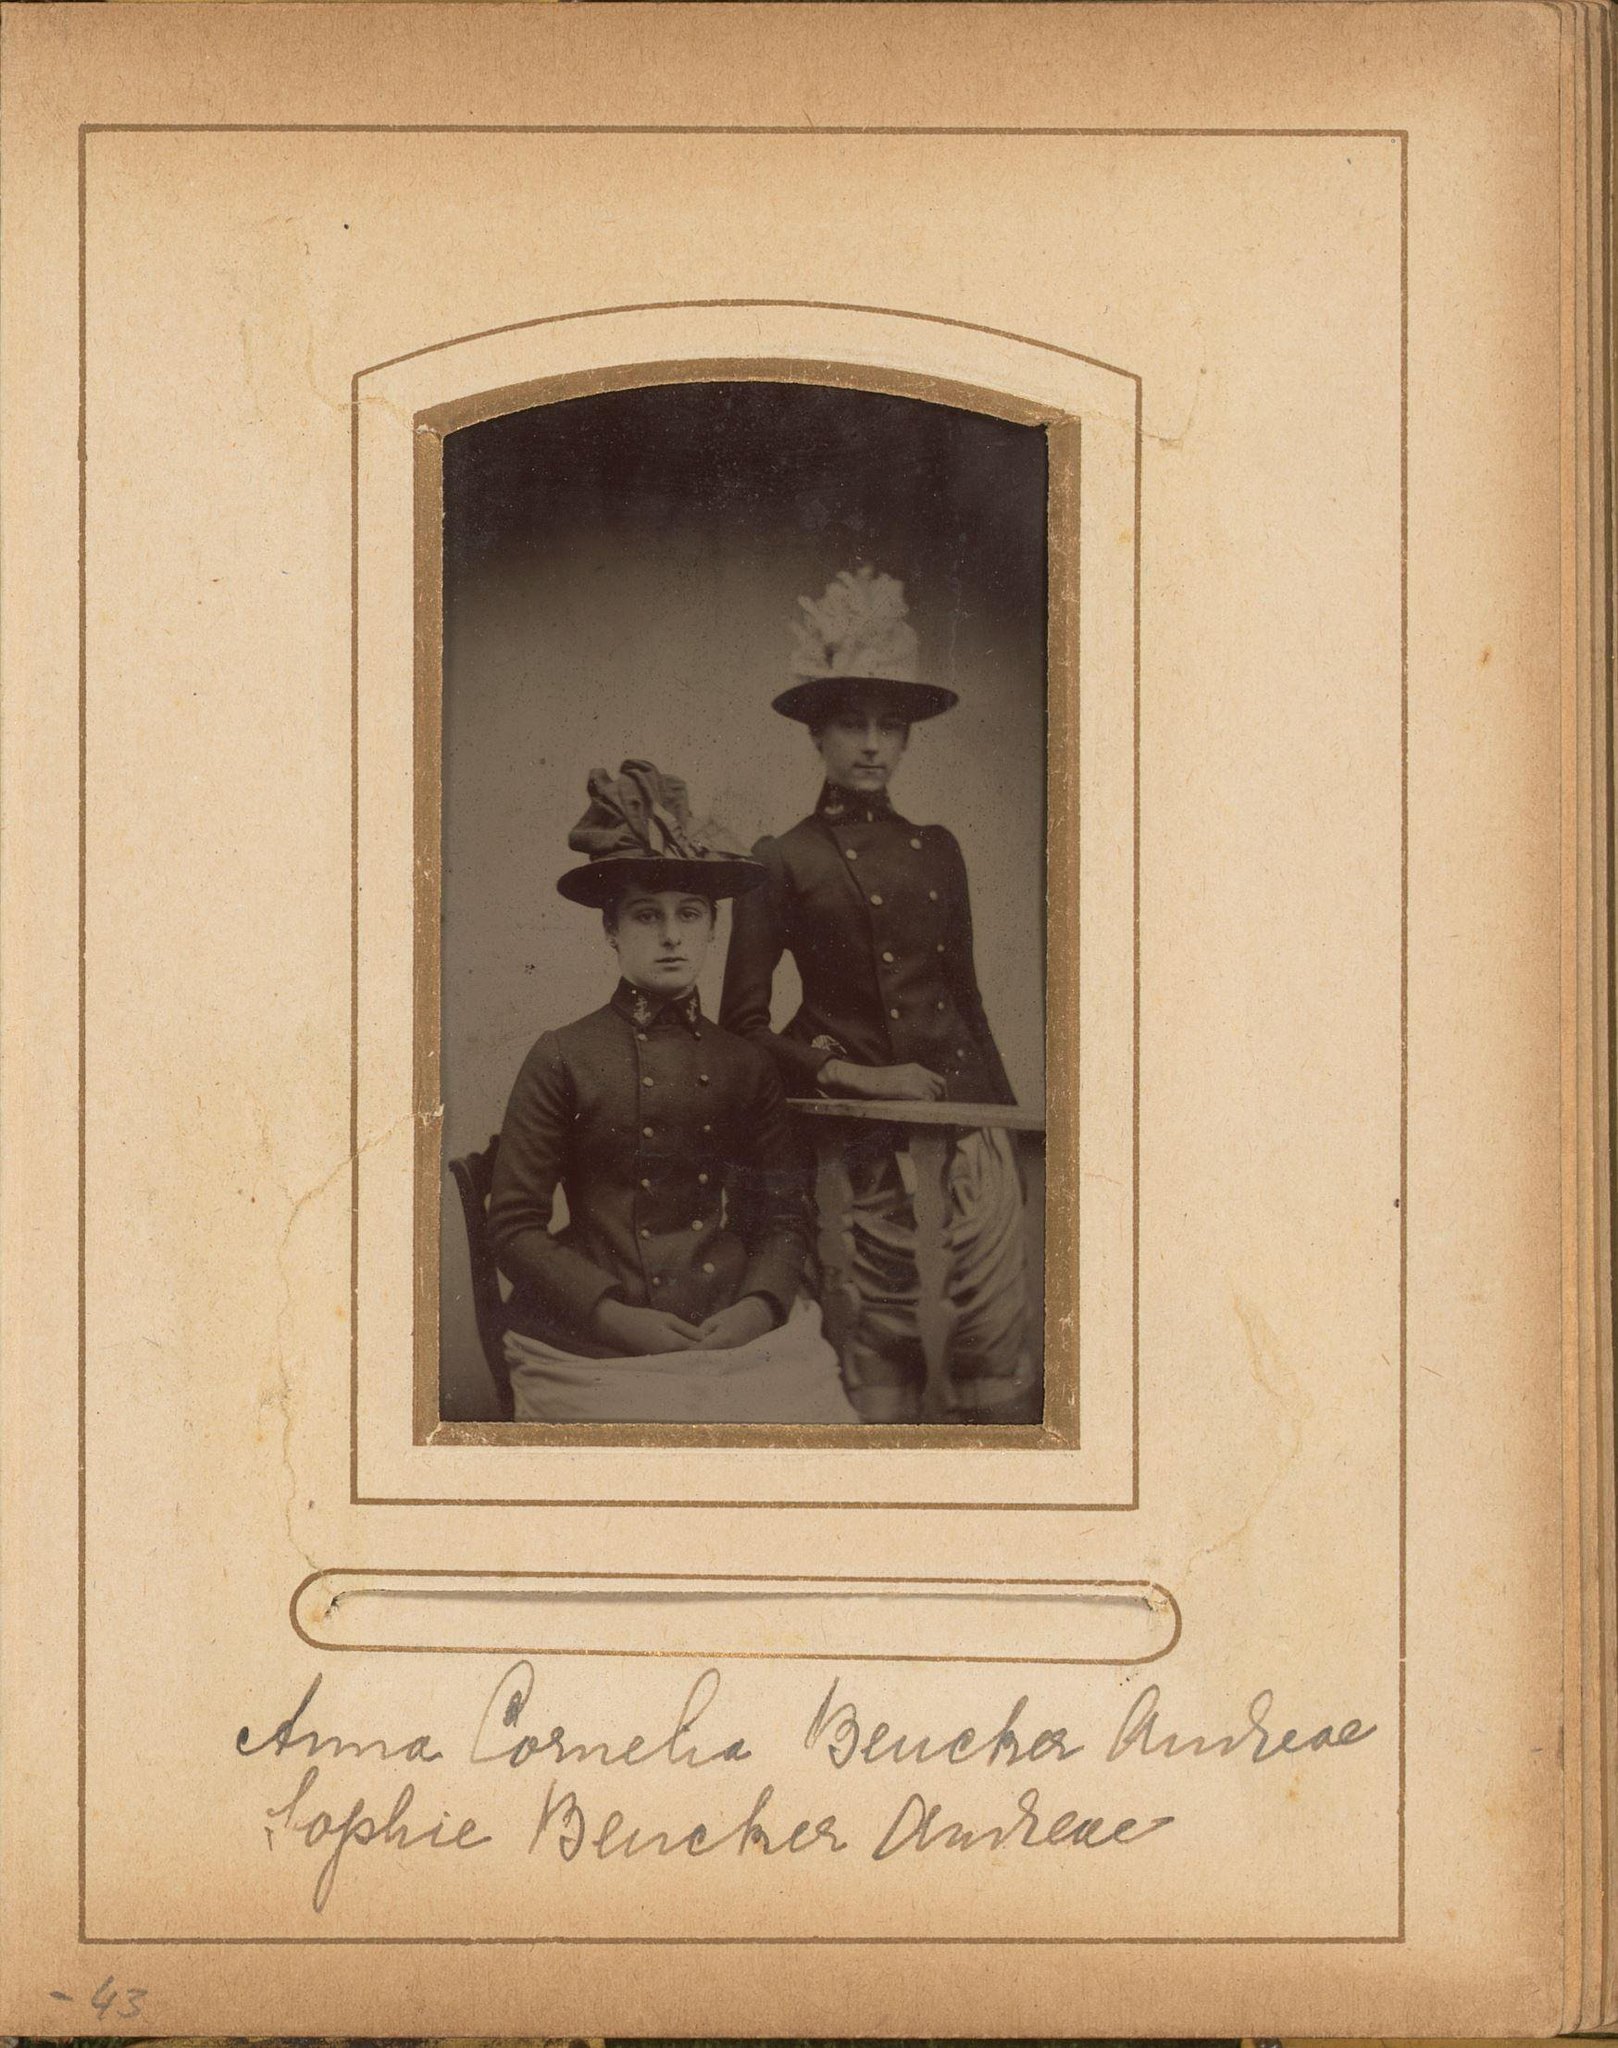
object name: photograph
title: Dubbelportret van Johanna Cornelia Beucker Andreae met haar zus Sophia Adriana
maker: Anonymous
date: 1895-1910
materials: metal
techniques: ferrotyping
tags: the hague, adult woman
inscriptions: inscription: ‘Anna Cornelia Beucker Andreae/ Sophie Beucker Andreae’